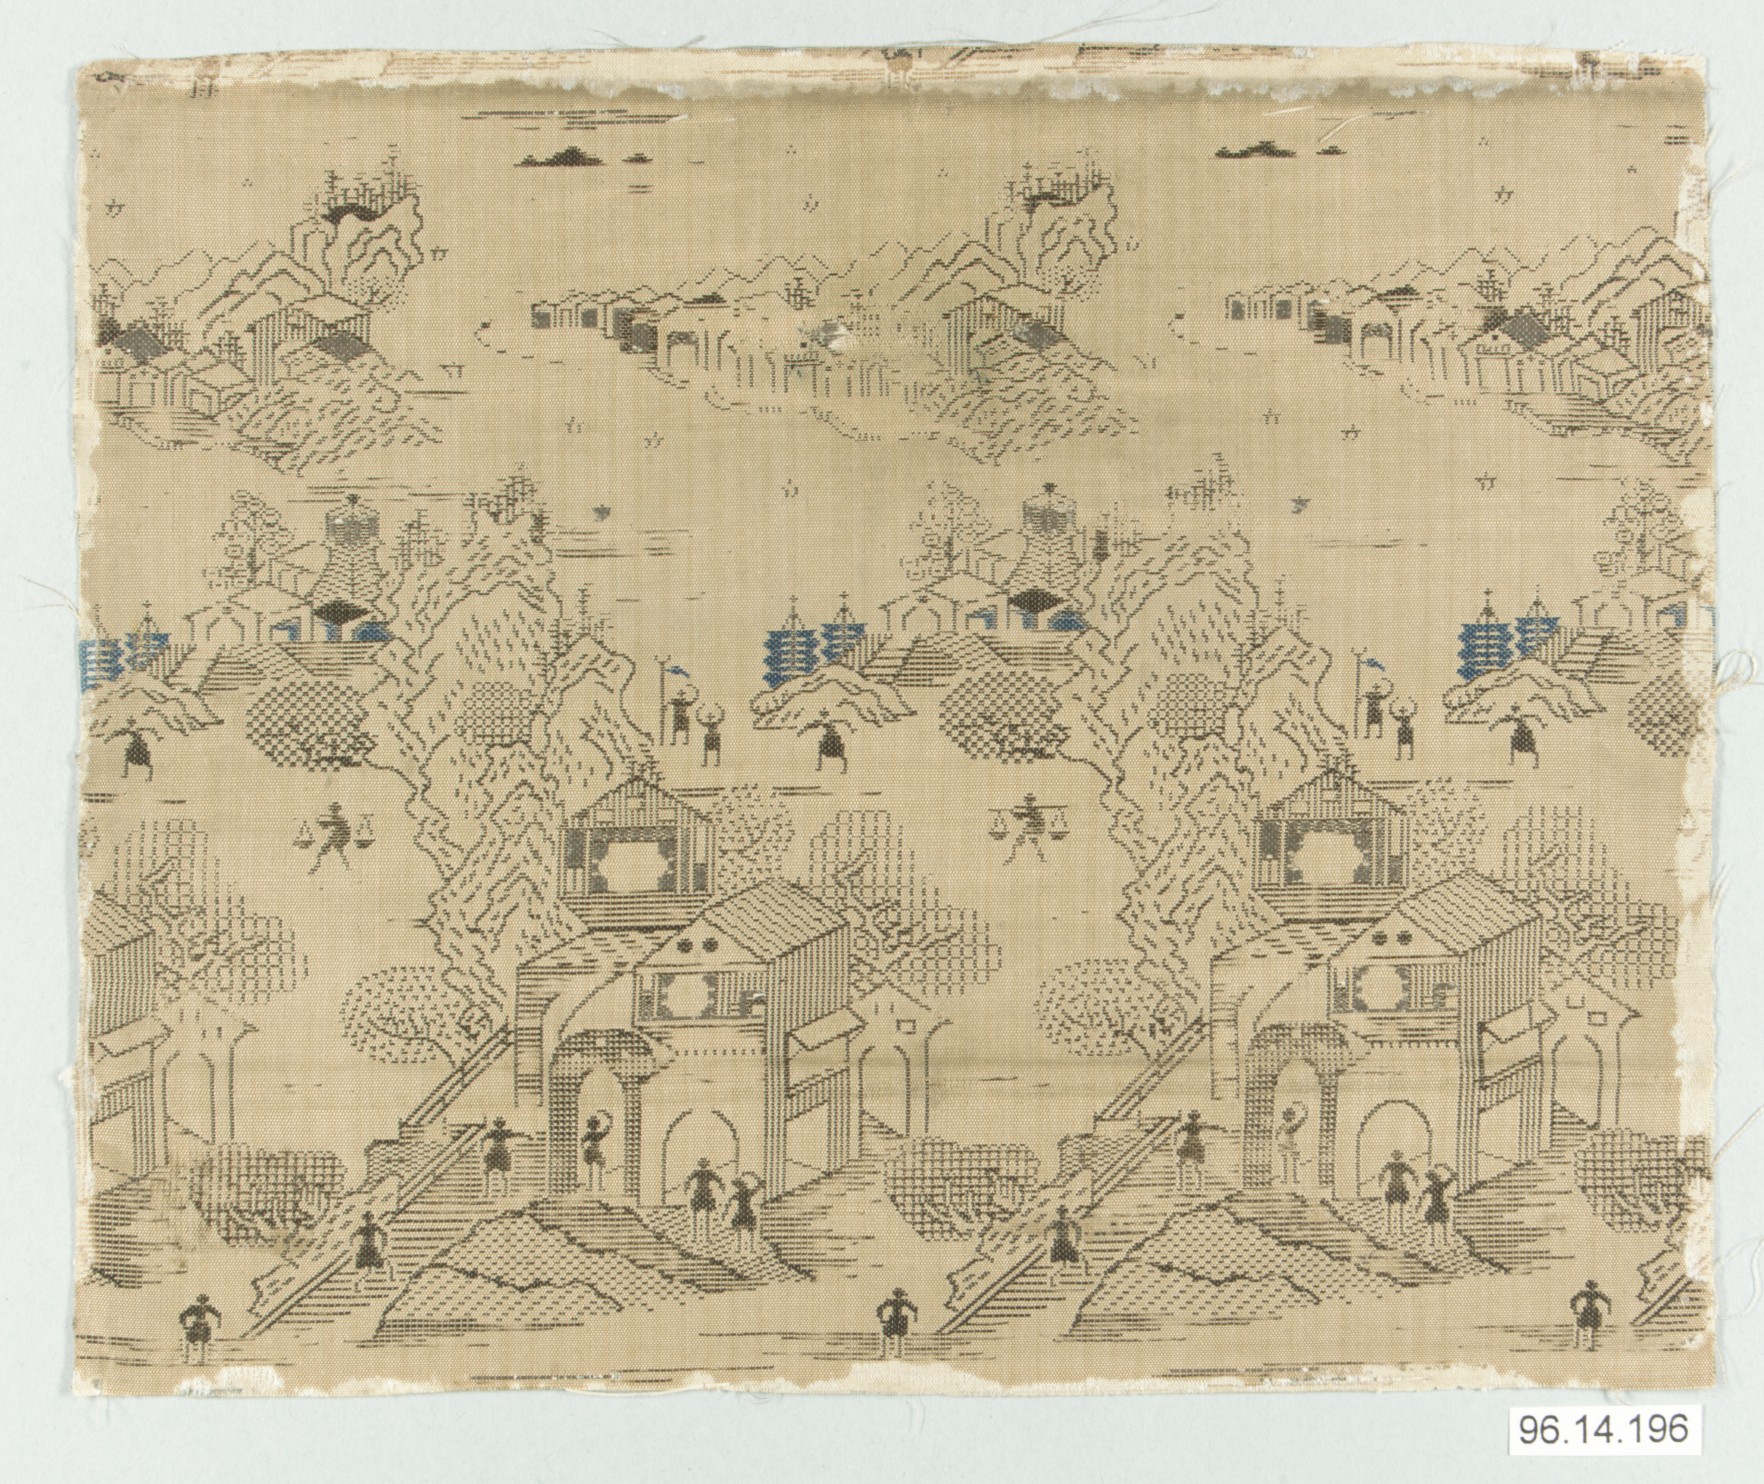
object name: piece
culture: japanese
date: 1801-1900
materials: metal thread, silk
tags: human figures